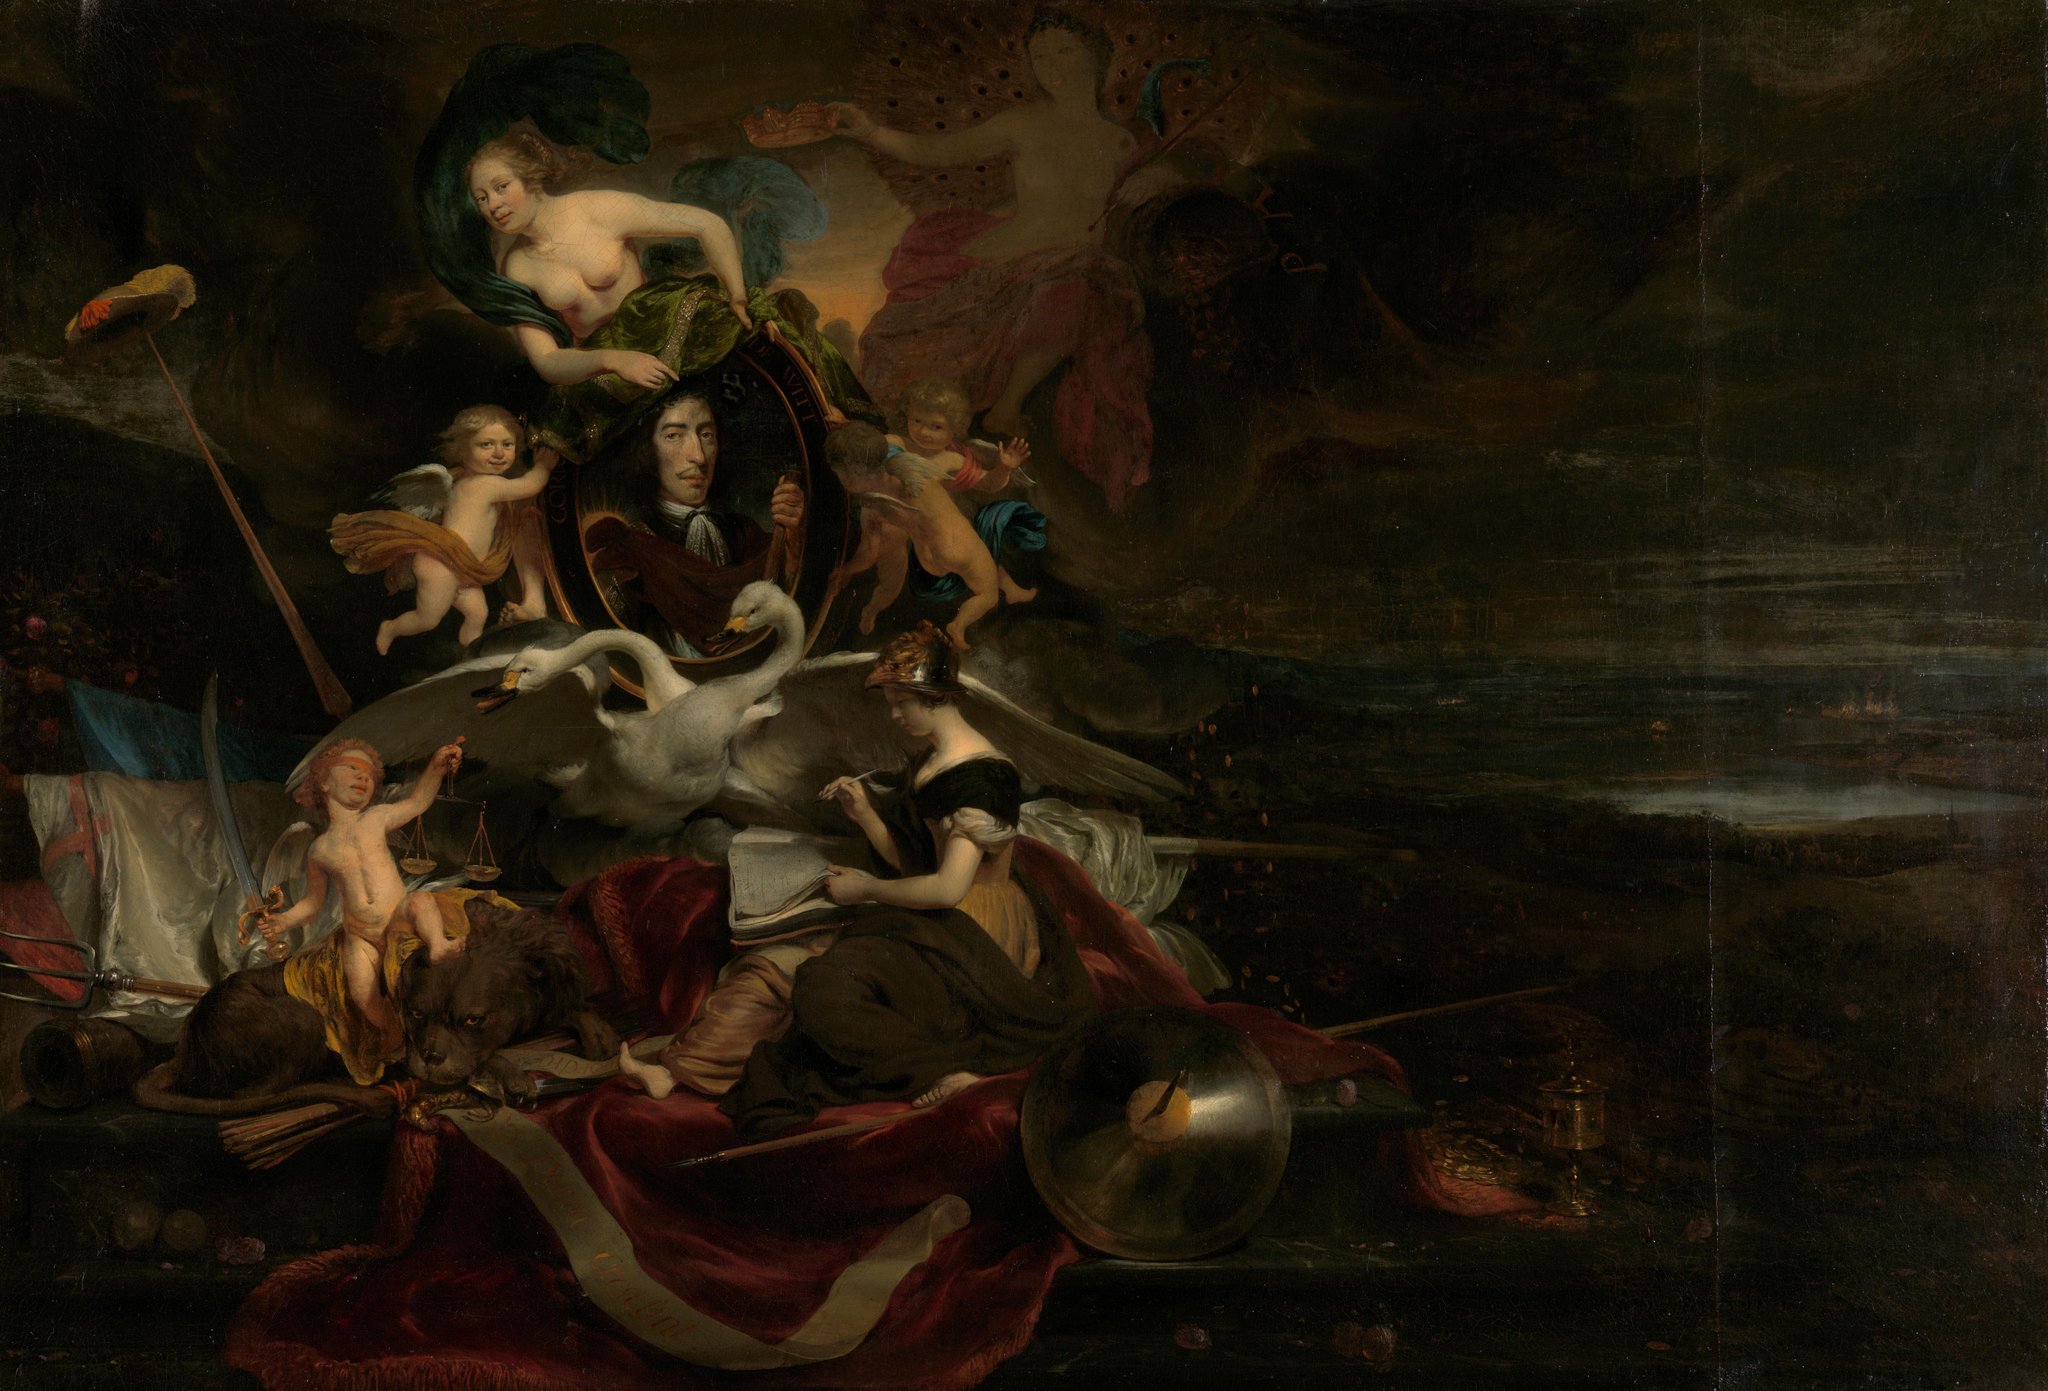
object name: painting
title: Allegory on the Dutch Raid on the Medway (1667), with a Portrait of Cornelis de Witt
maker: cornelis bisschop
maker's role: print maker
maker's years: 1630-1674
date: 1668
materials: canvas, oil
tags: flushing, michiel adriaenszoon de ruyter, cornelis de witt, the hague, politician, johan de witt, water-birds: swan, historical persons, victory, 'historia'; 'historia' (ripa), raid on the medway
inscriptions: signature and date: ‘C. Bischop Fecit 1668’, inscription: ‘Concordia ... Res Parvae Crescunt’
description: Allegorie op de Tocht naar Chatham in 1667 met een portret van Cornelis de Witt. Het ovale portret omgeven door symbolen van de Vrede, Rechtvaardigheid (geblinddoekt kind met weegschalen), Vrijheid (lans met vrijheidshoed) en Eendracht (tekst op het banier). Verder ook geldstukken, twee witte zwanen, een leeuw, een schild en verschillende wapens.